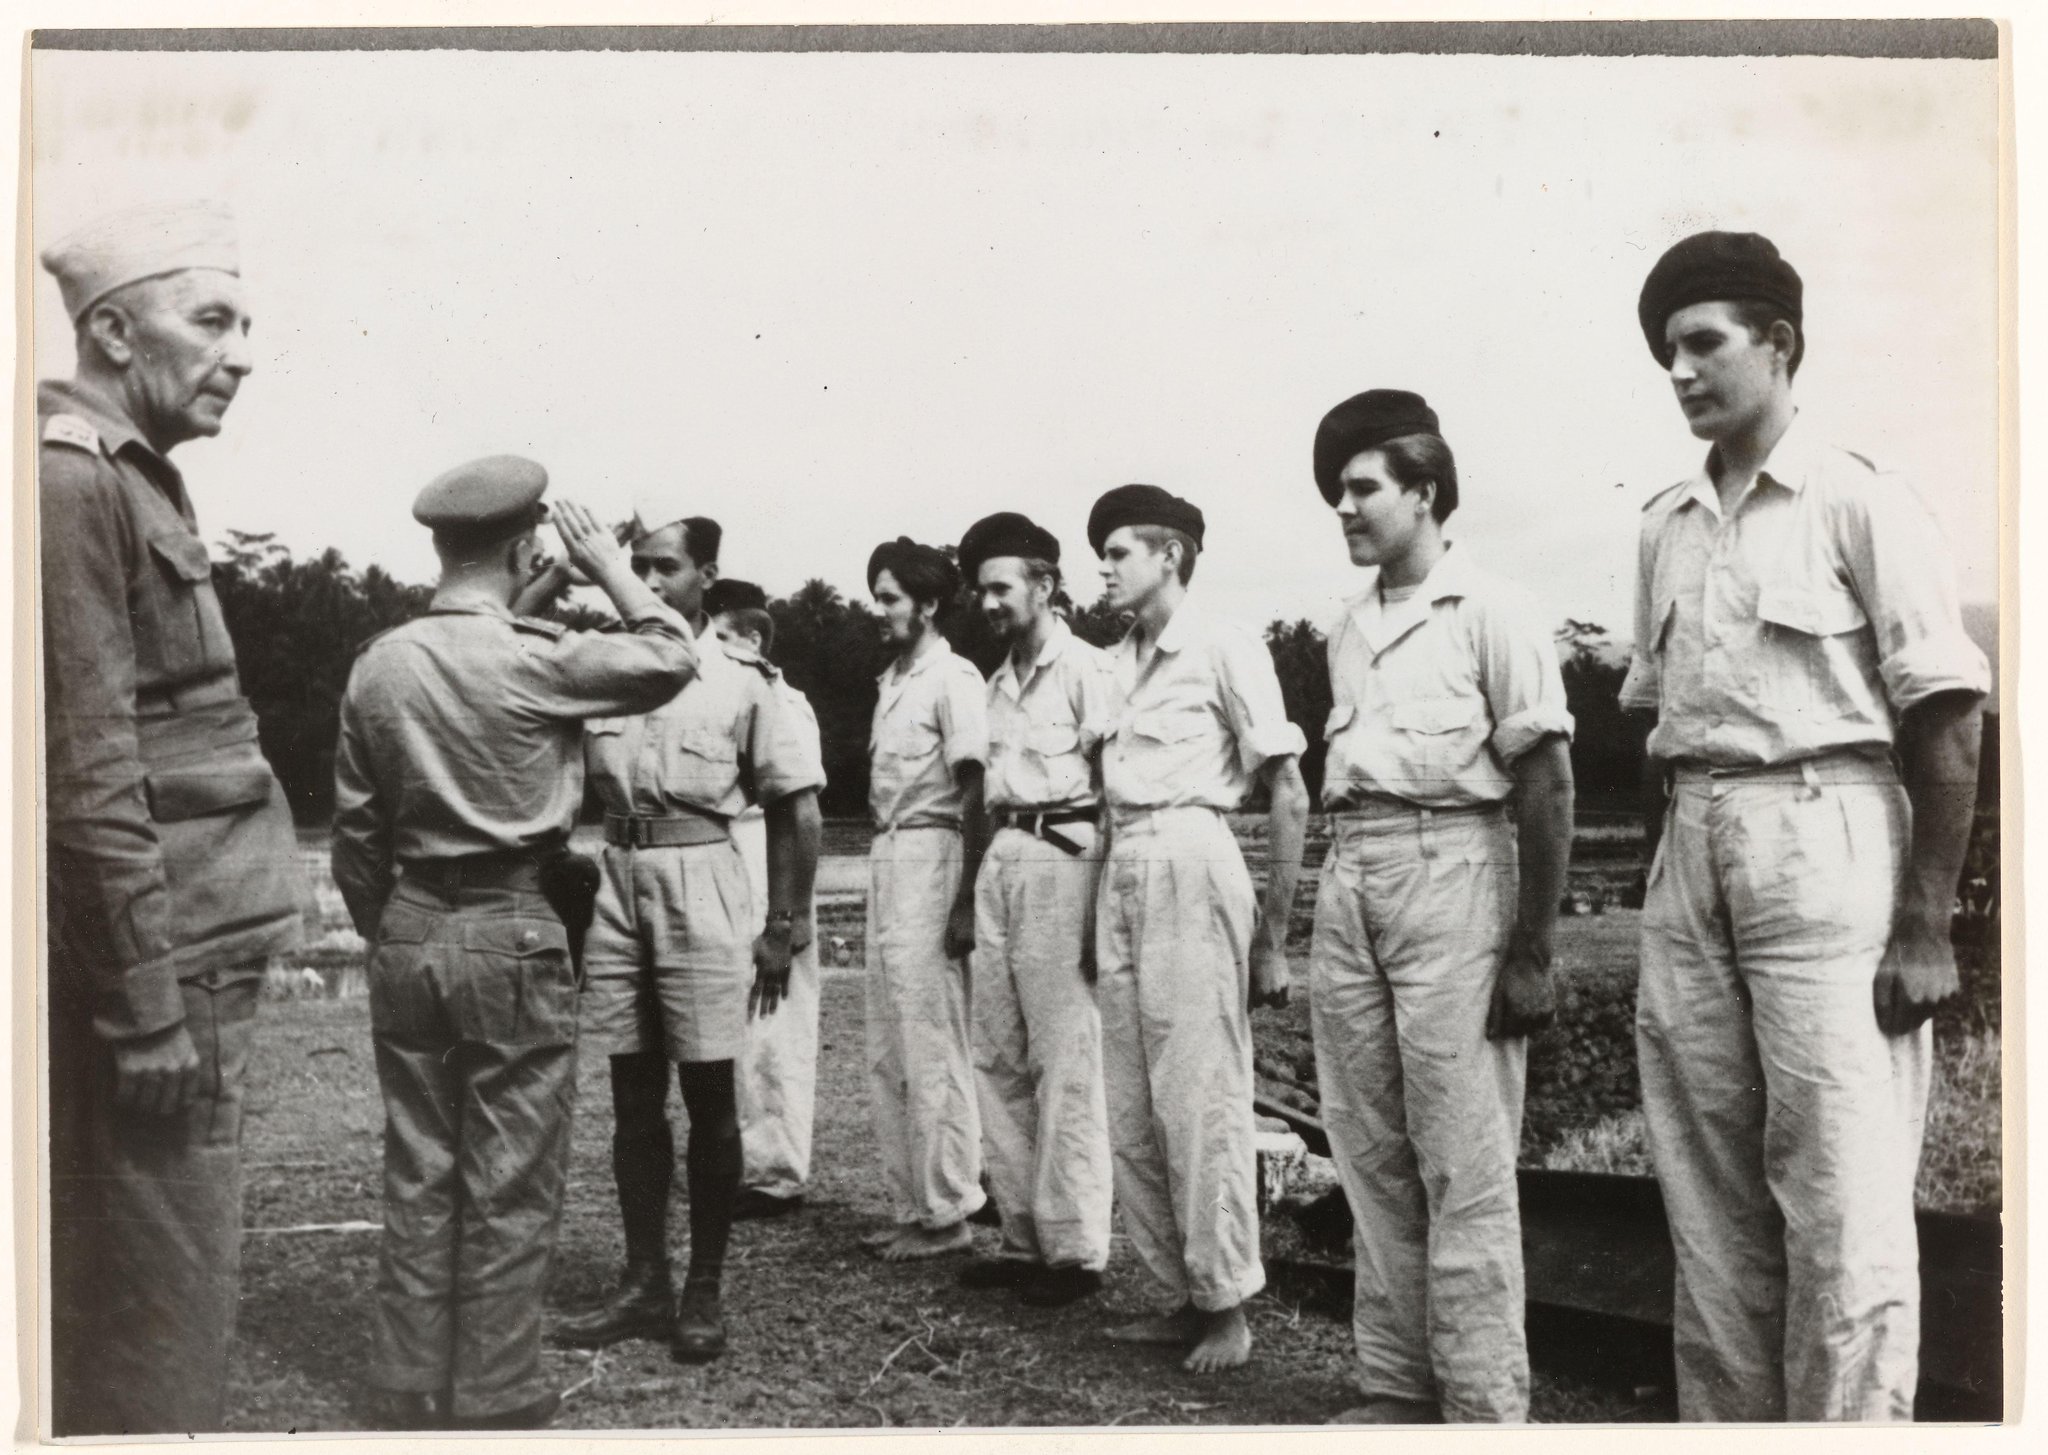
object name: photograph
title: Uitwisseling van gevangenen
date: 1949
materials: photographic support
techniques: photography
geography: java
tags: exchange ~prinsoner of war, java, dutch east indies, the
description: Zes Nederlandse militairen die vermist werden worden uitgewisseld tegen 39 leden van het Republikeinse leger (TRI), 29 september 1949.